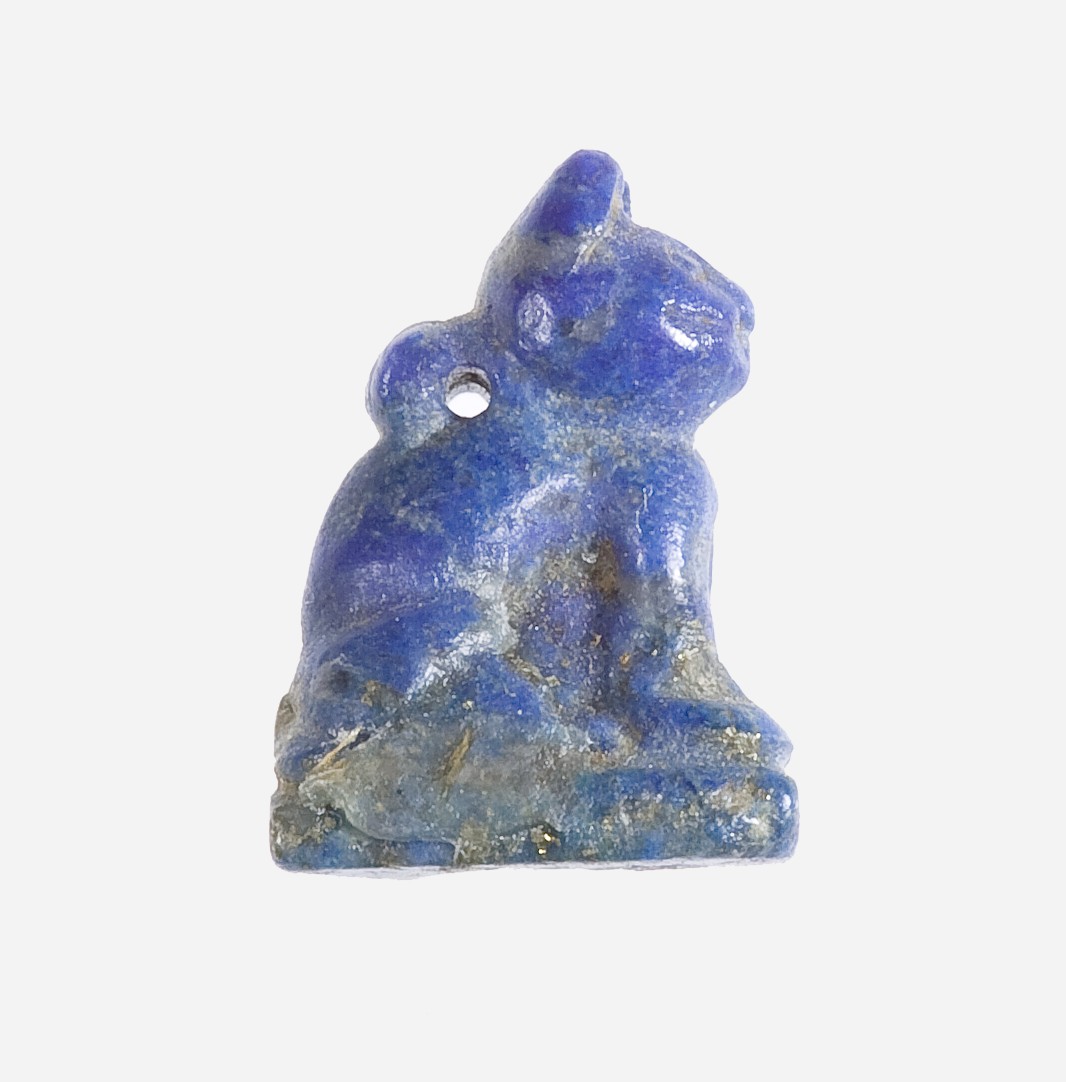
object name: amulet, cat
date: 1550-1295 BCE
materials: lapis lazuli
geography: egypt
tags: cats